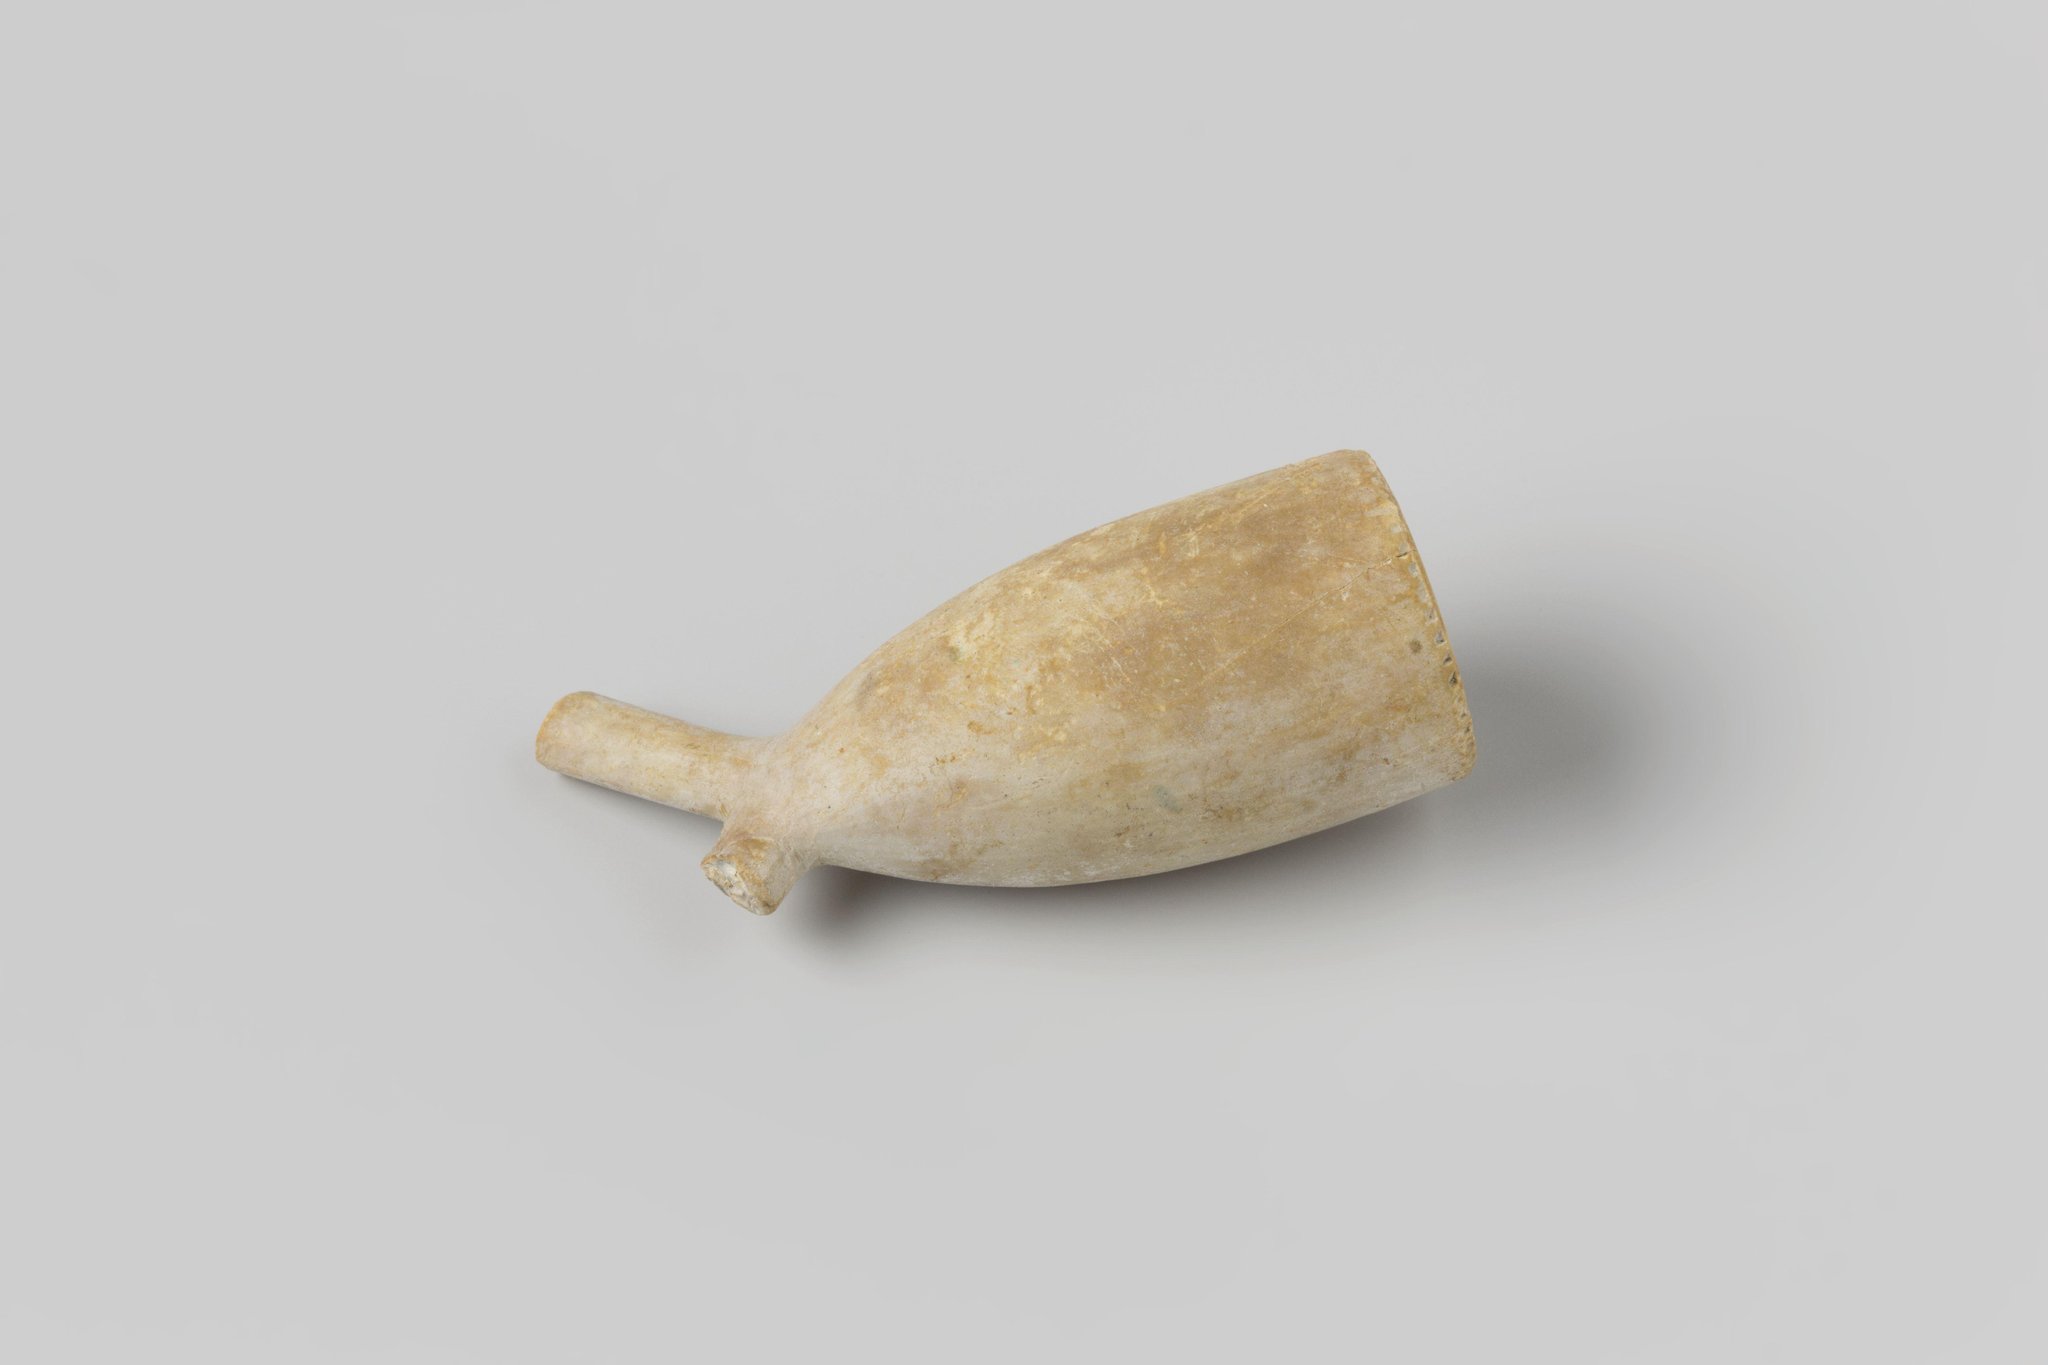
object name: pipe bowl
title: Pijpenkop uit het wrak van de Oost-Indiëvaarder Hollandia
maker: Anonymous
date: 1700-1743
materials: clay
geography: netherlands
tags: verenigde oostindische compagnie, hollandia (schip), annet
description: Pipe, bowl, heelmark: crowned 91; 1hsm1.